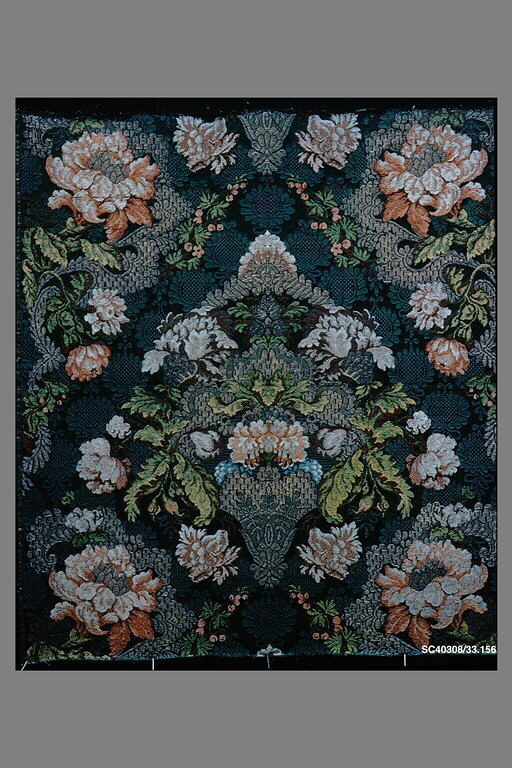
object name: piece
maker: jean revel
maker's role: designer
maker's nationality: french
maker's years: 1684-1751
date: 1735-1740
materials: metal thread, silk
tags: flowers,leaves